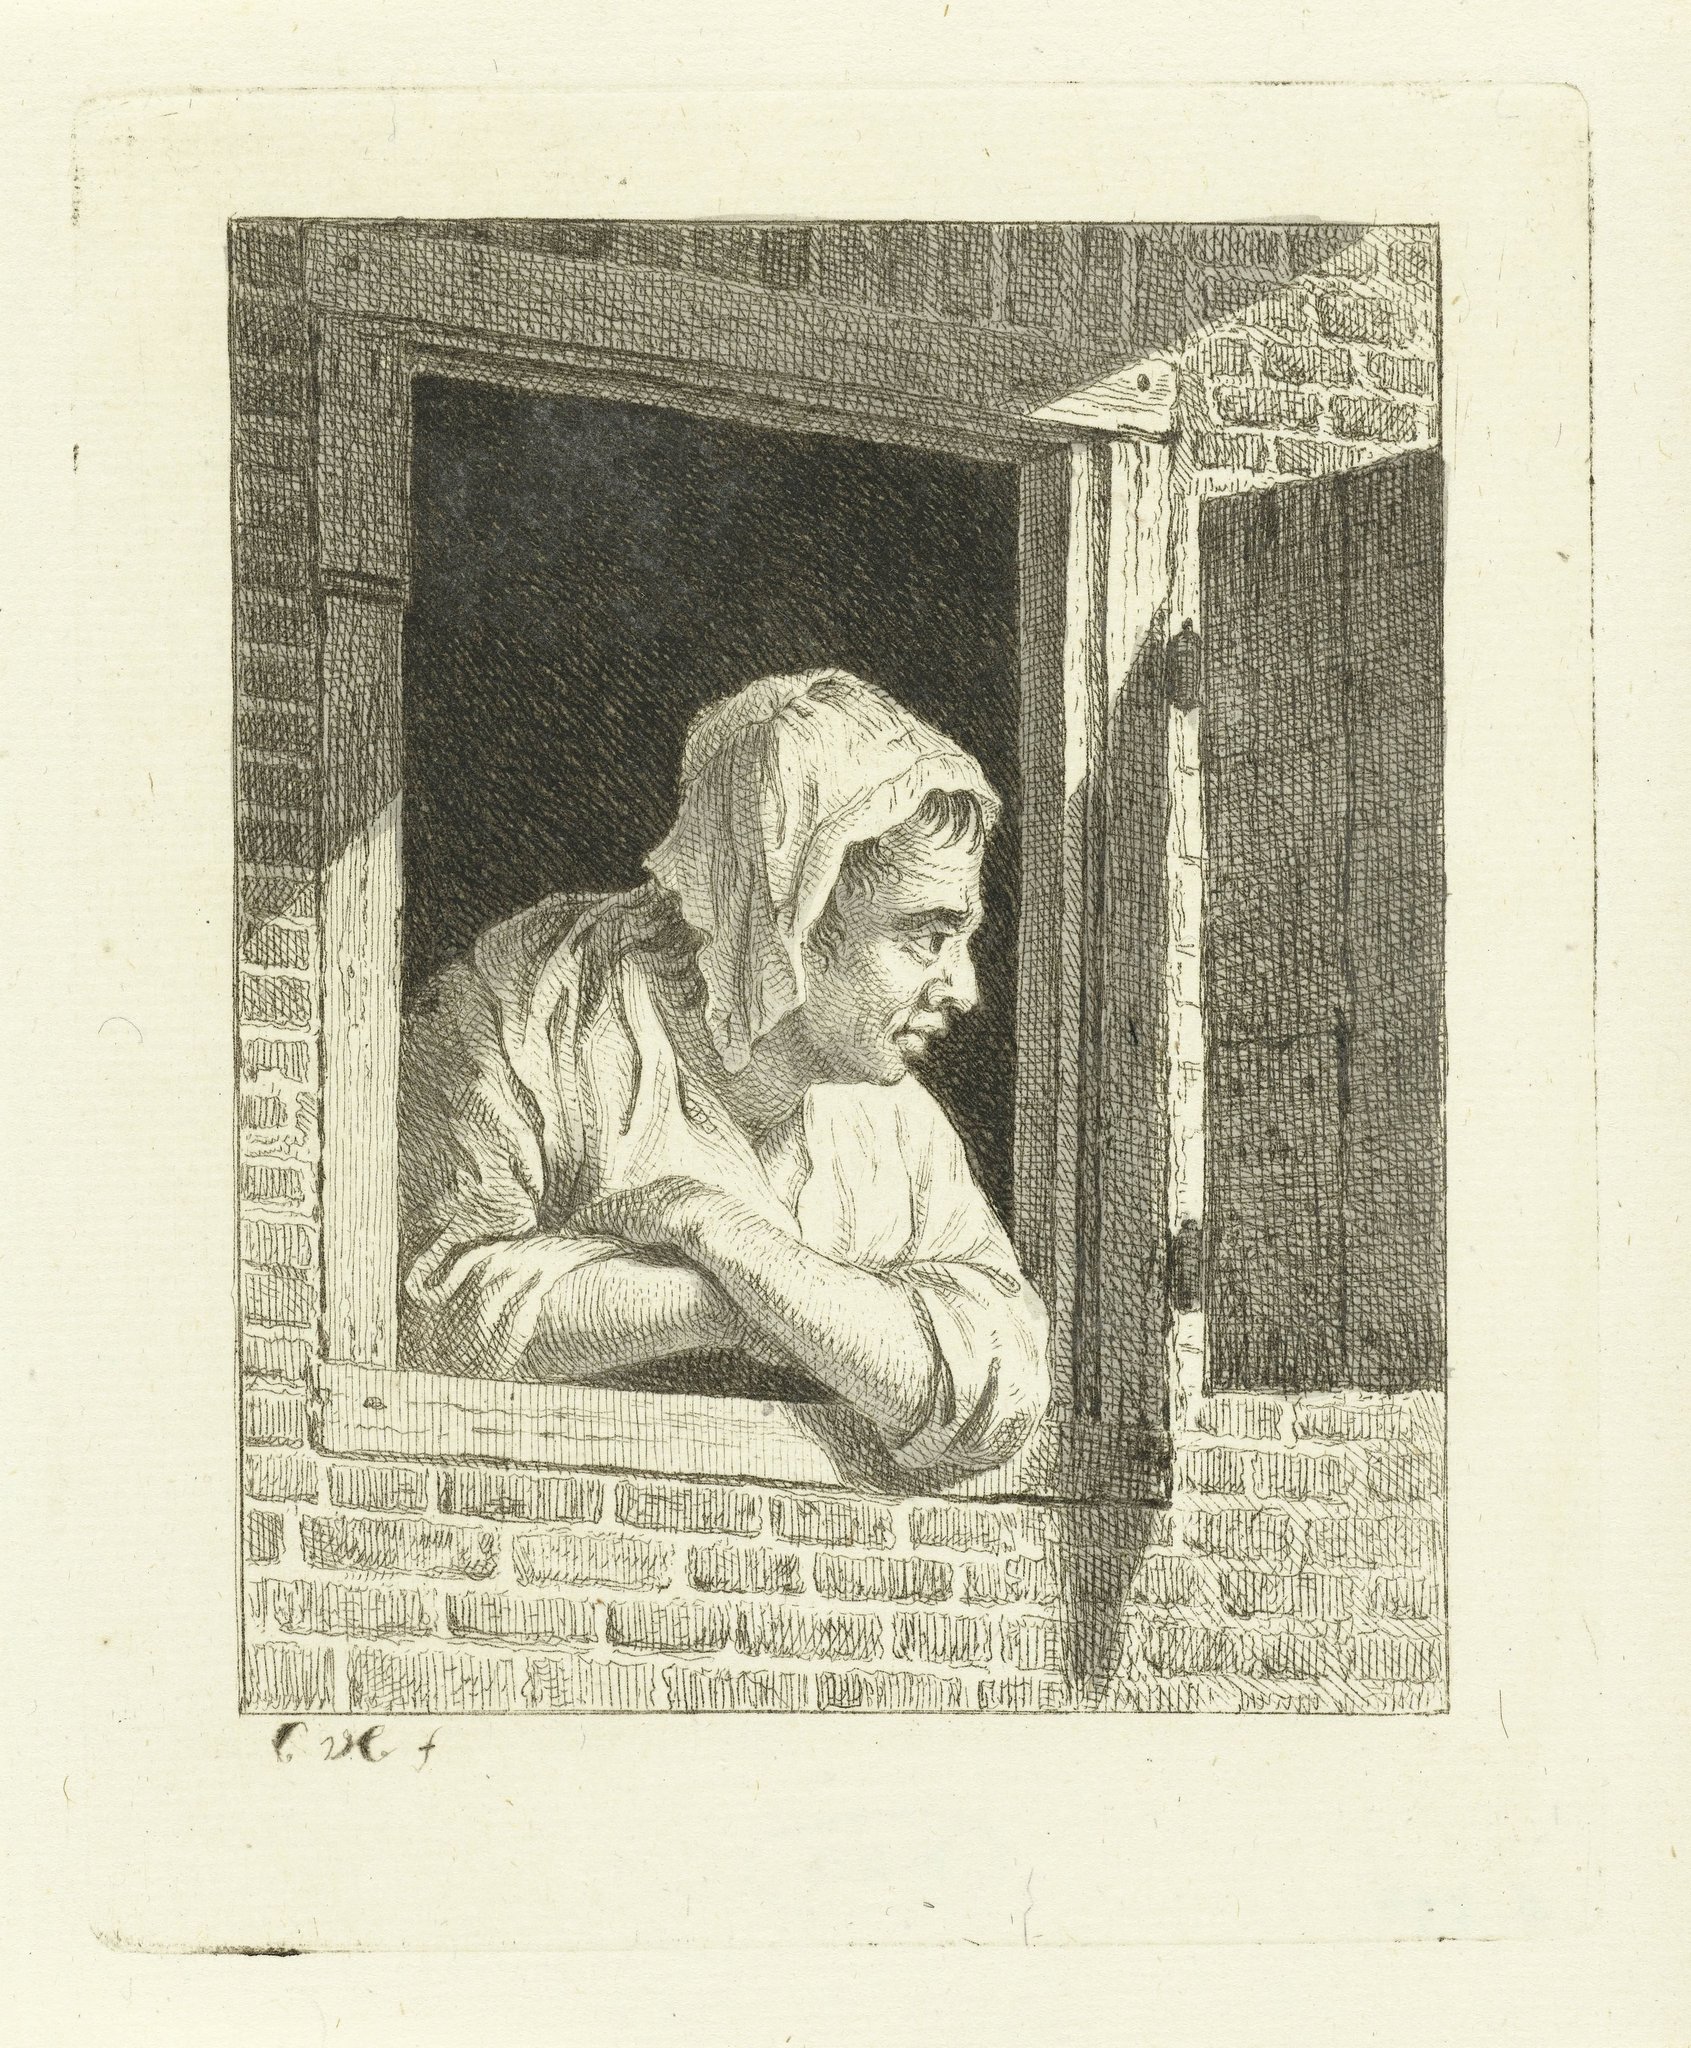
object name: print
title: Vrouw leunend op armen in raamopening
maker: cornelis van cuijlenburgh (ii)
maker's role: painter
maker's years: 1758-1827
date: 1768-1827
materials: paper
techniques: etching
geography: netherlands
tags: human figure at (open) window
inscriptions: collector's mark: Lugt 2228